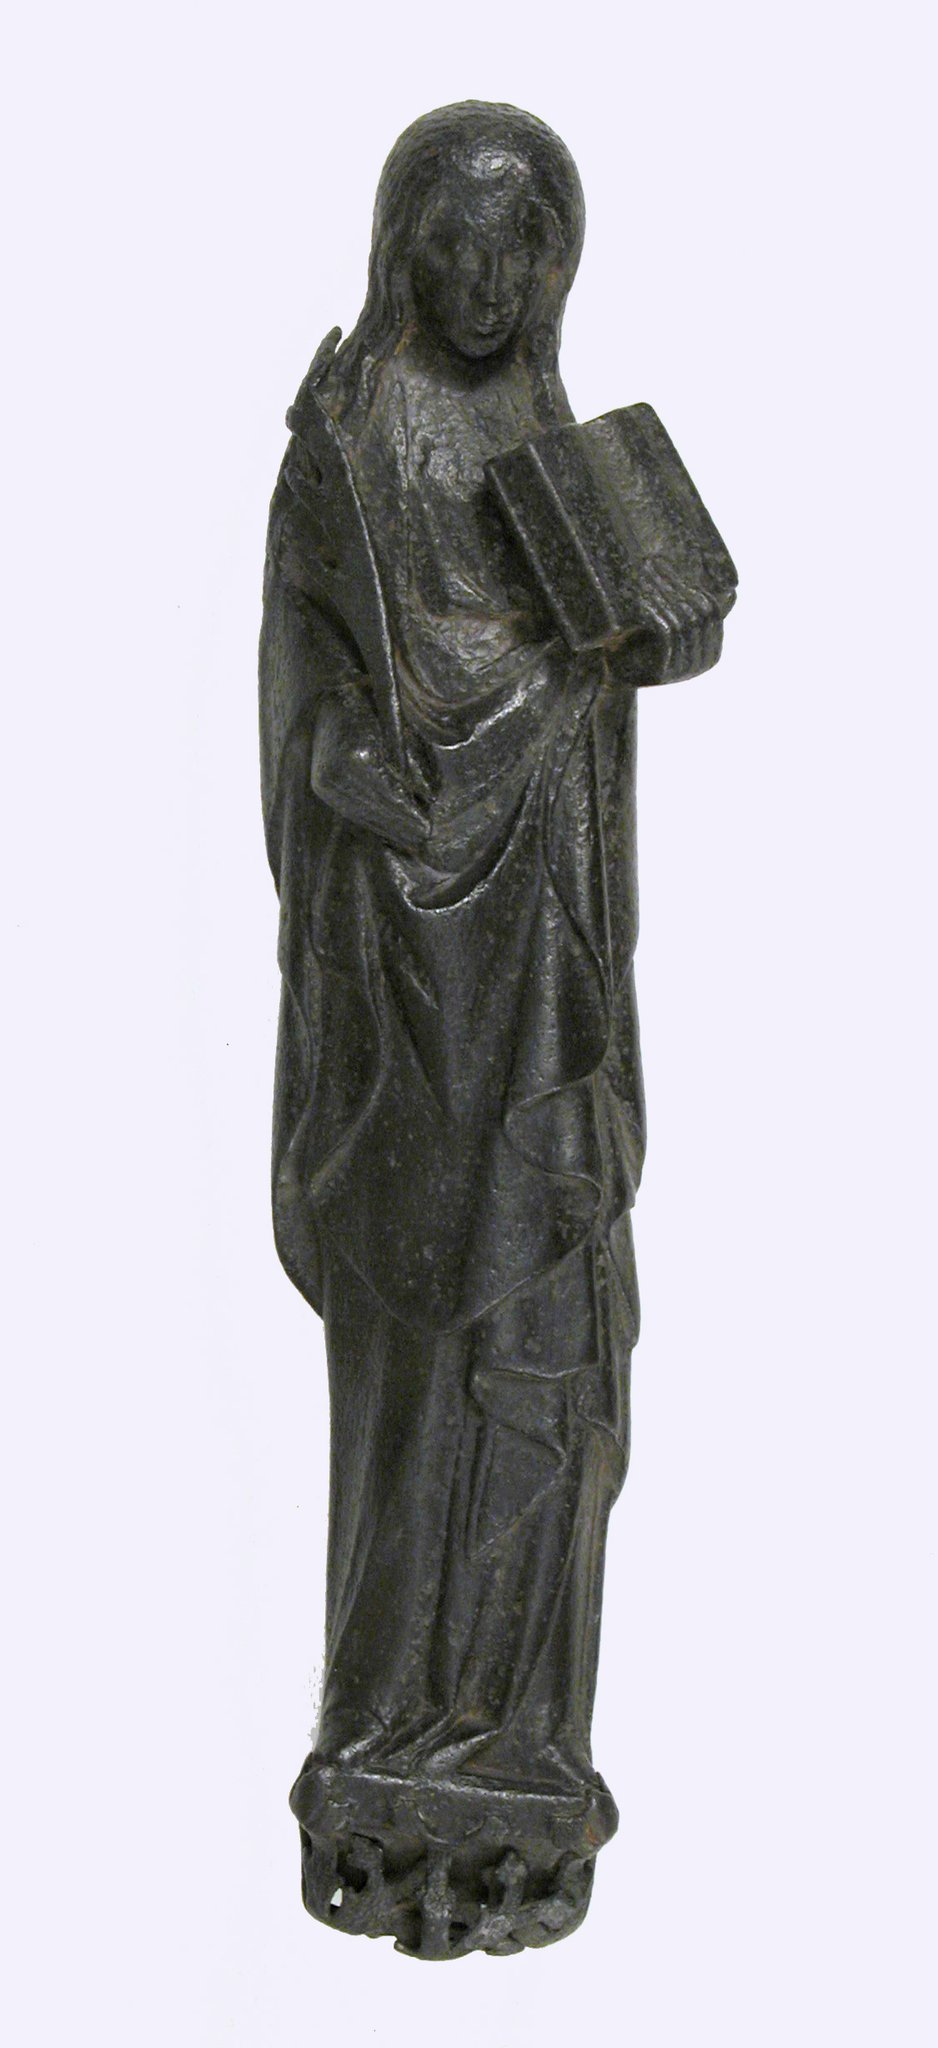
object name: door knocker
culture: french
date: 1401-1500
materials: iron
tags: women